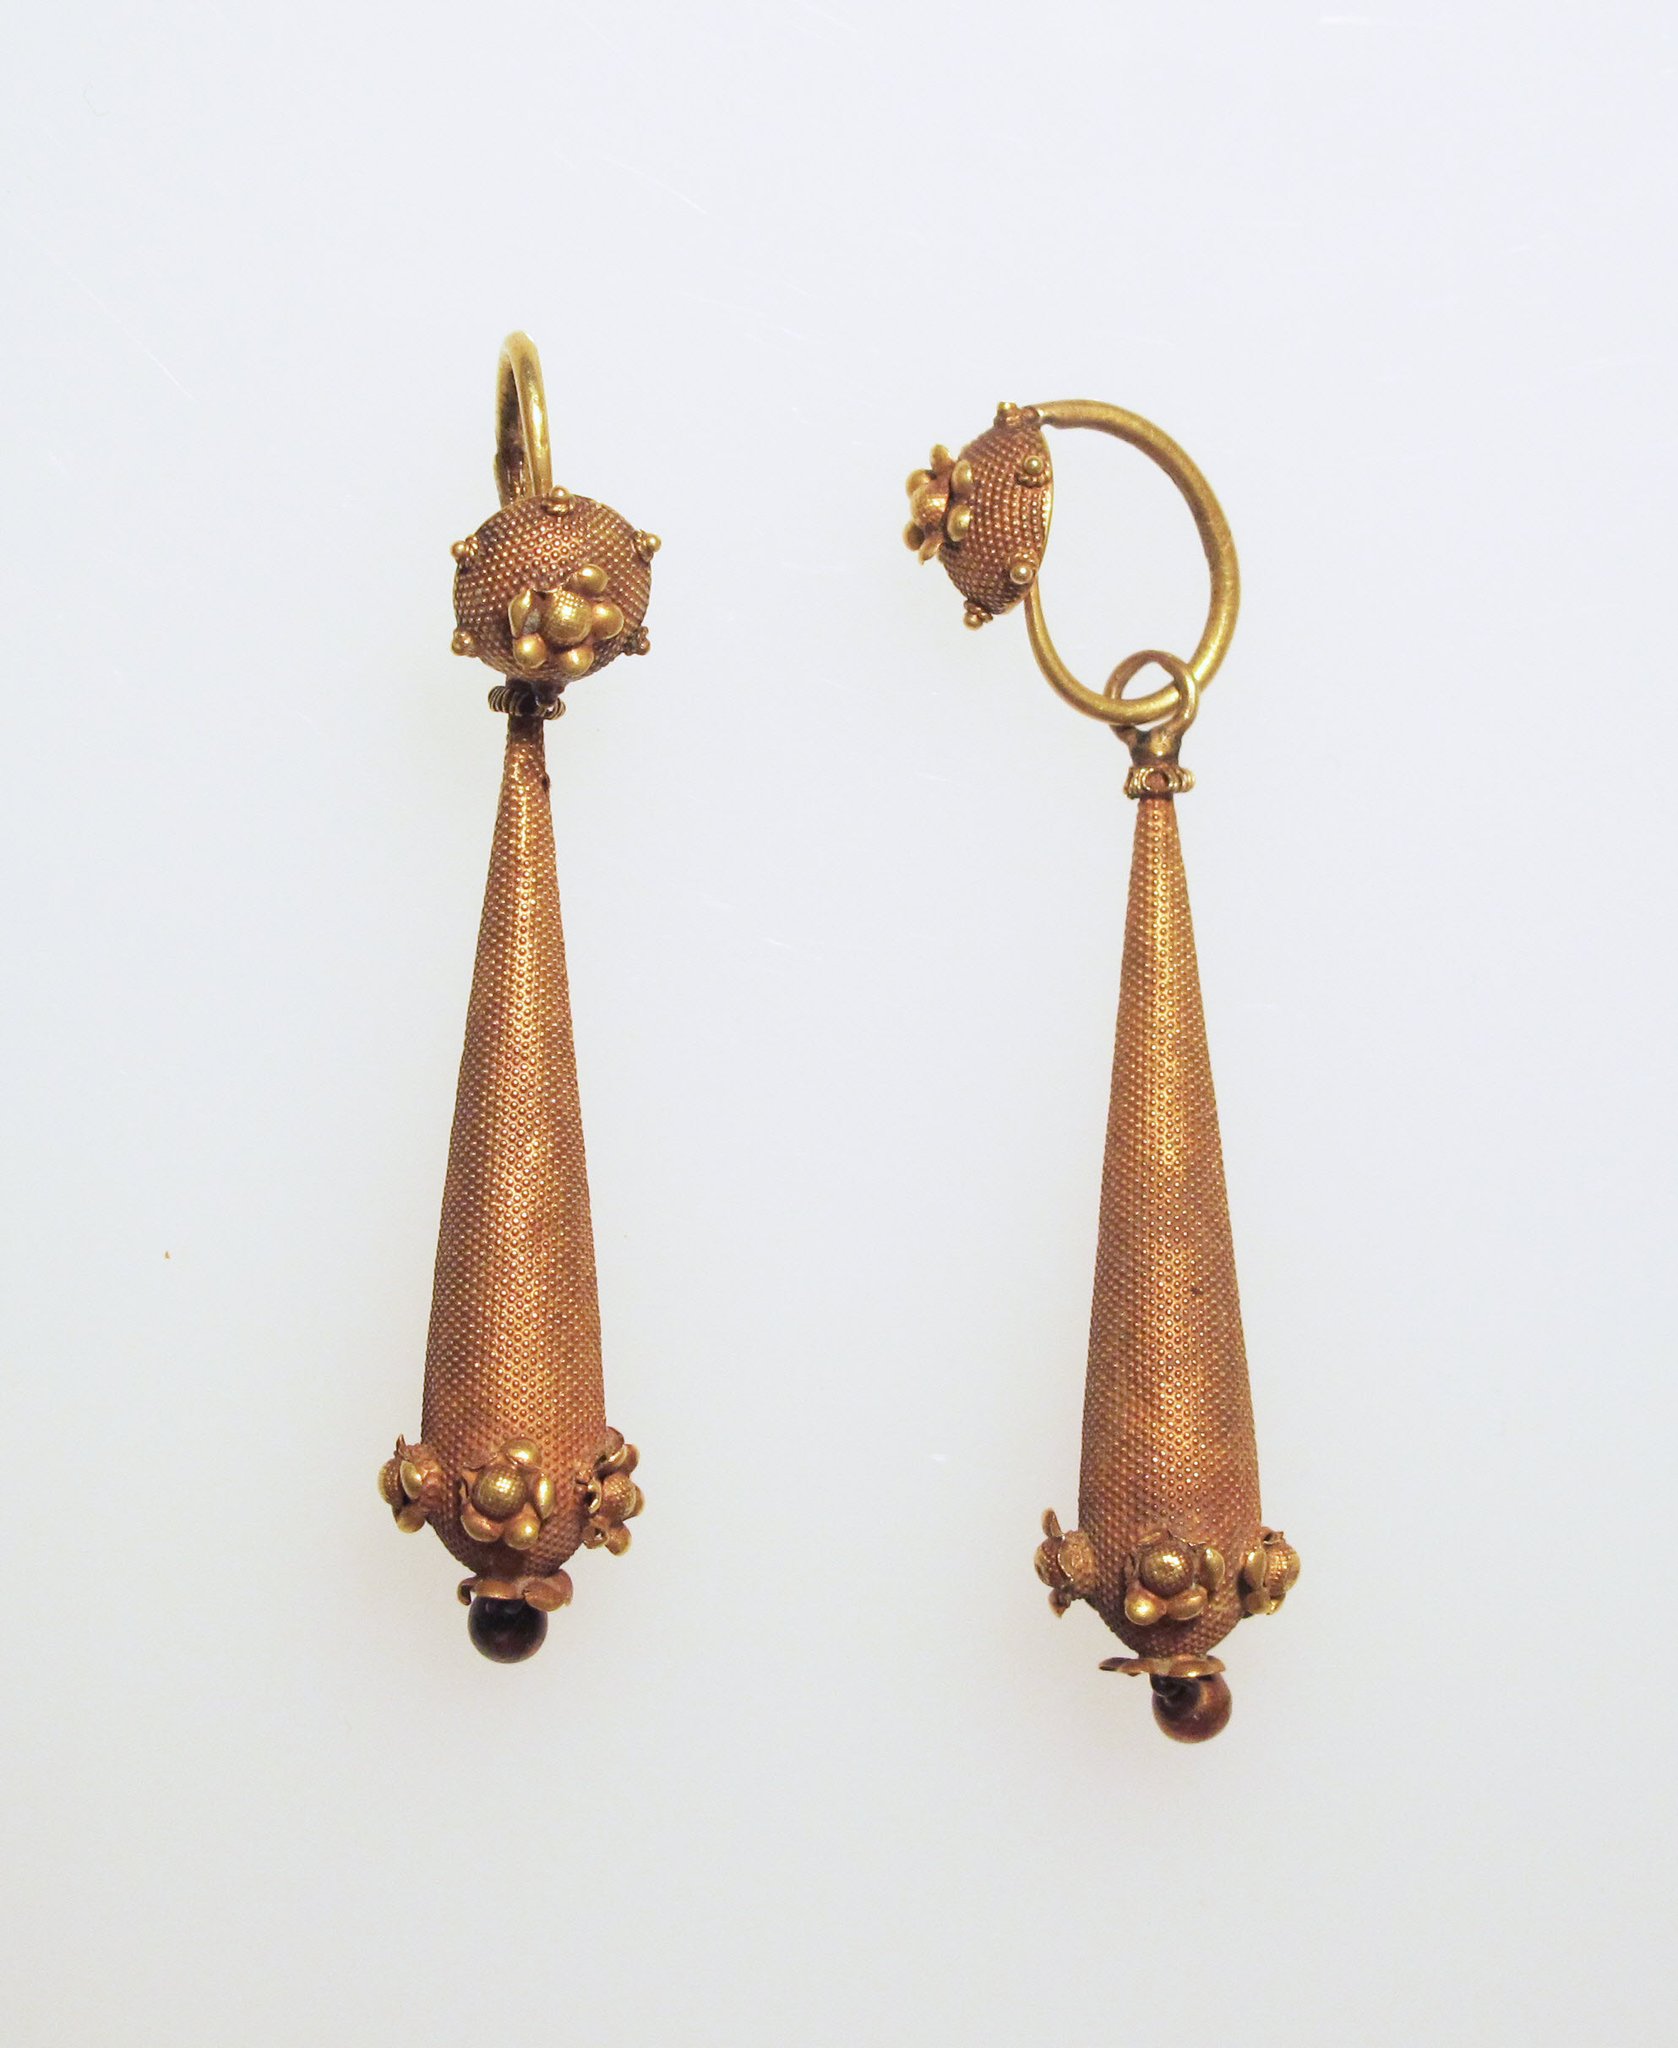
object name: earring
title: Earring rosette and pendant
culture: greek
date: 323 BCE-31 CE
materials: gold